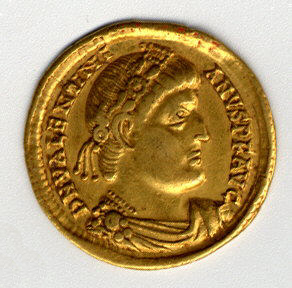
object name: solidus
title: Gold Solidus of Valentinian I (364–75)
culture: byzantine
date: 364-375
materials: gold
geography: nicomedia (now izmit, turkey)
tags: profiles